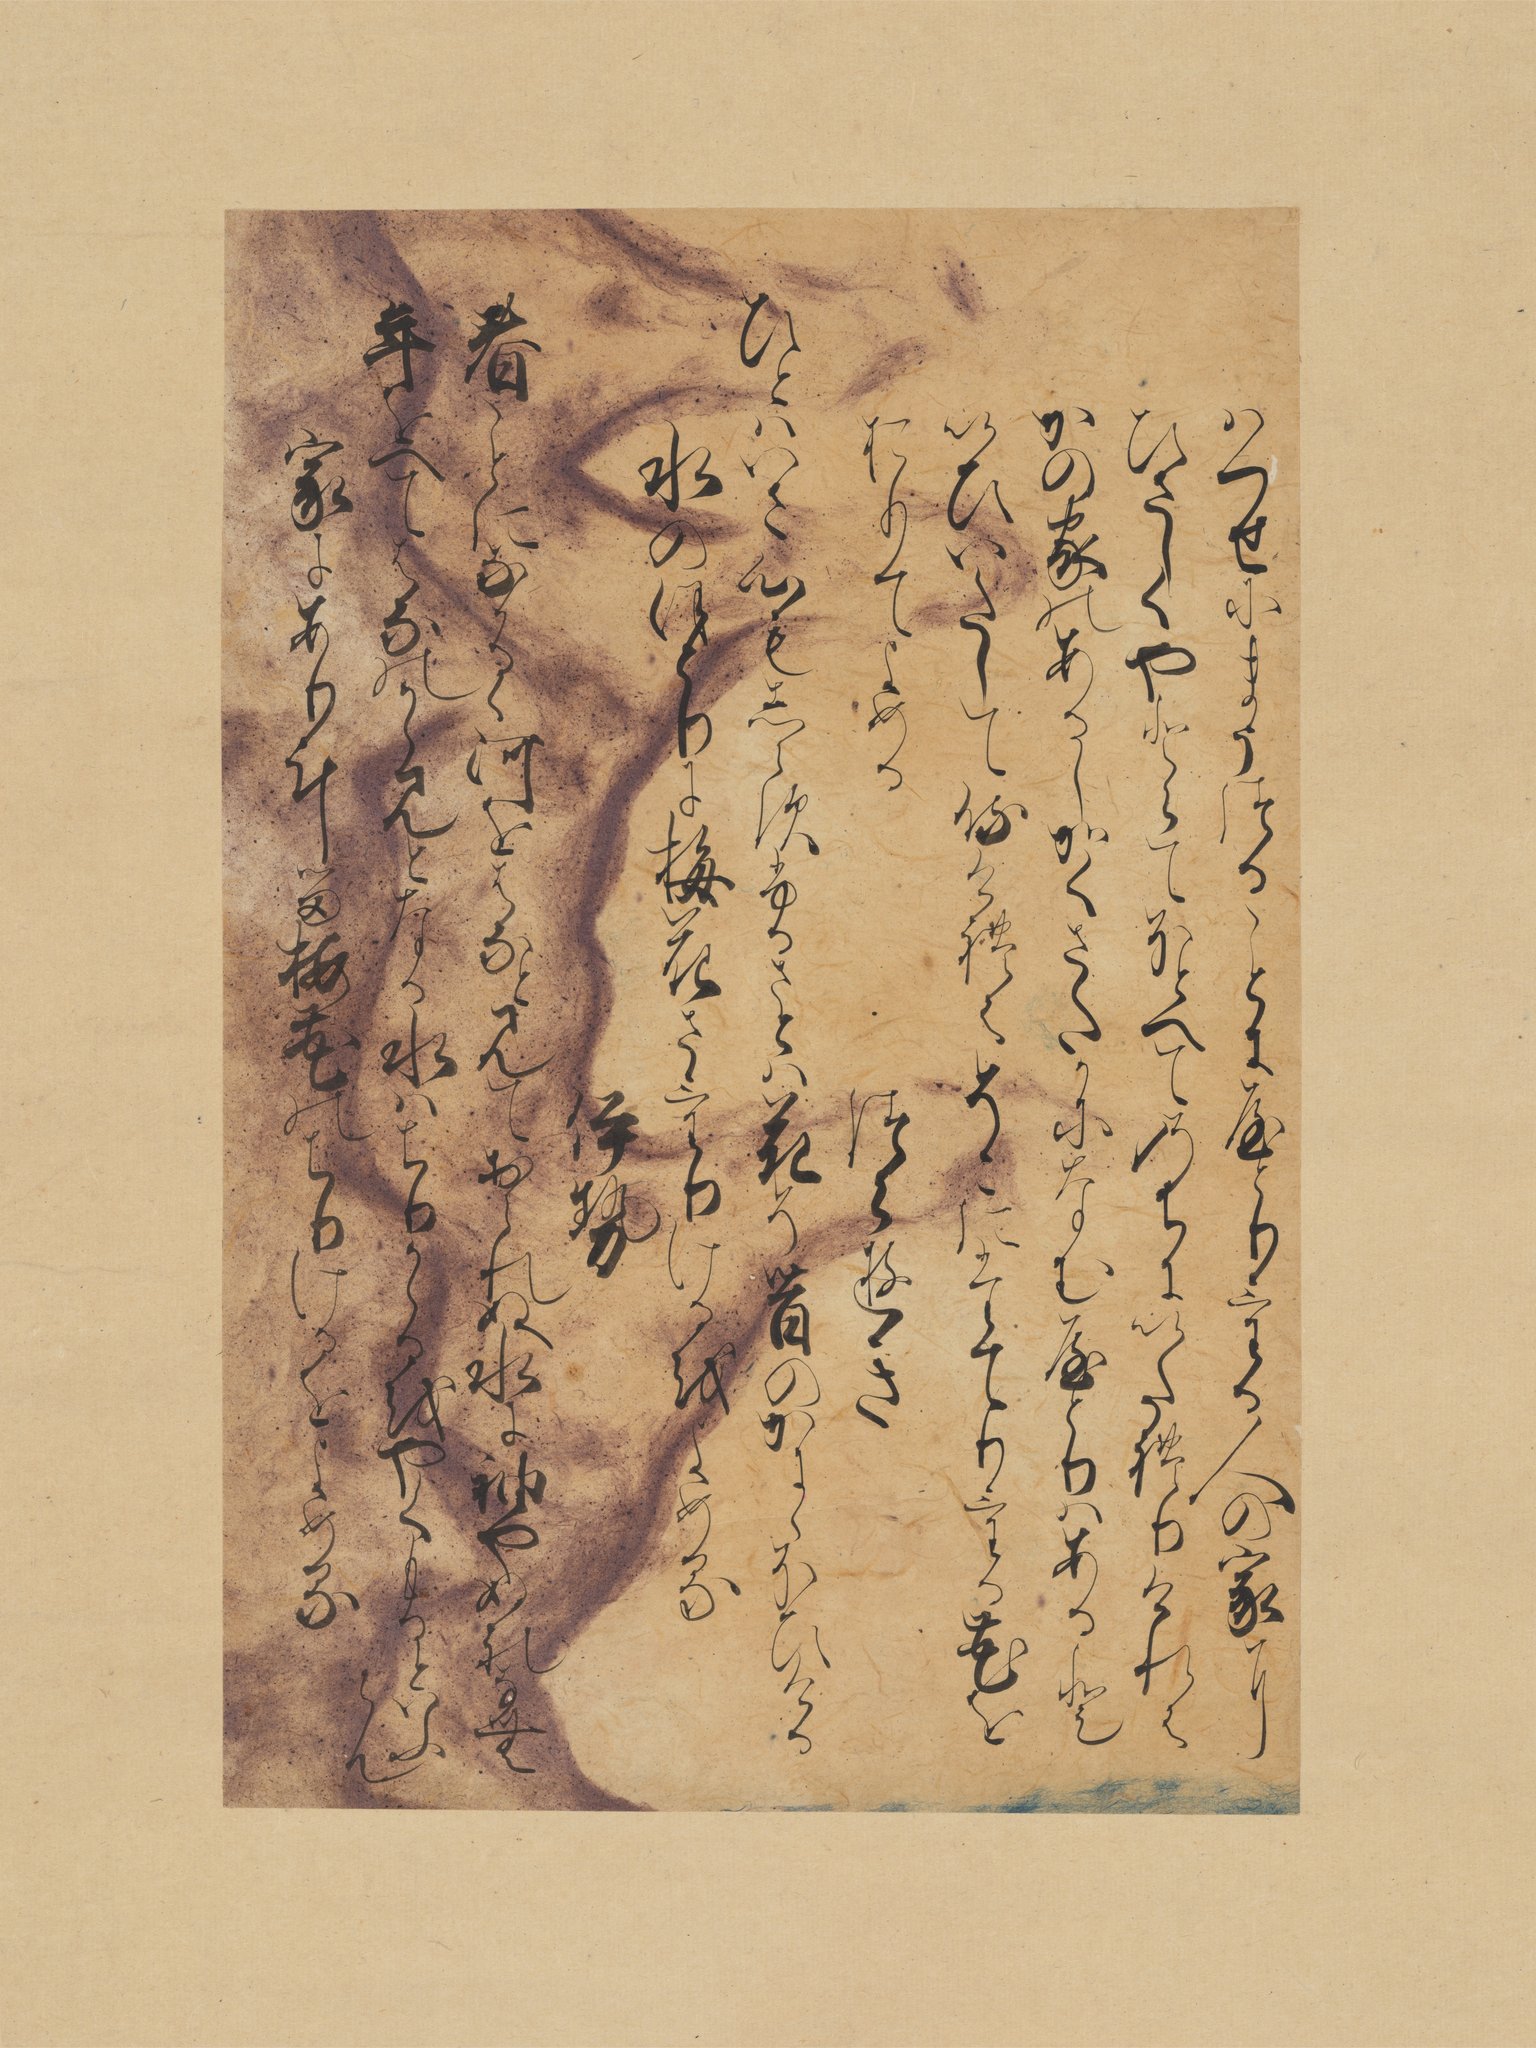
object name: hanging scroll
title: Poems about Cherry Blossoms, one of the “Murasame Fragments” (Murasame-gire)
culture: japanese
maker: nijō tameyo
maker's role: artist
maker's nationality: japanese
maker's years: 1250-1338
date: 1301-1333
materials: ink, paper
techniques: dyeing